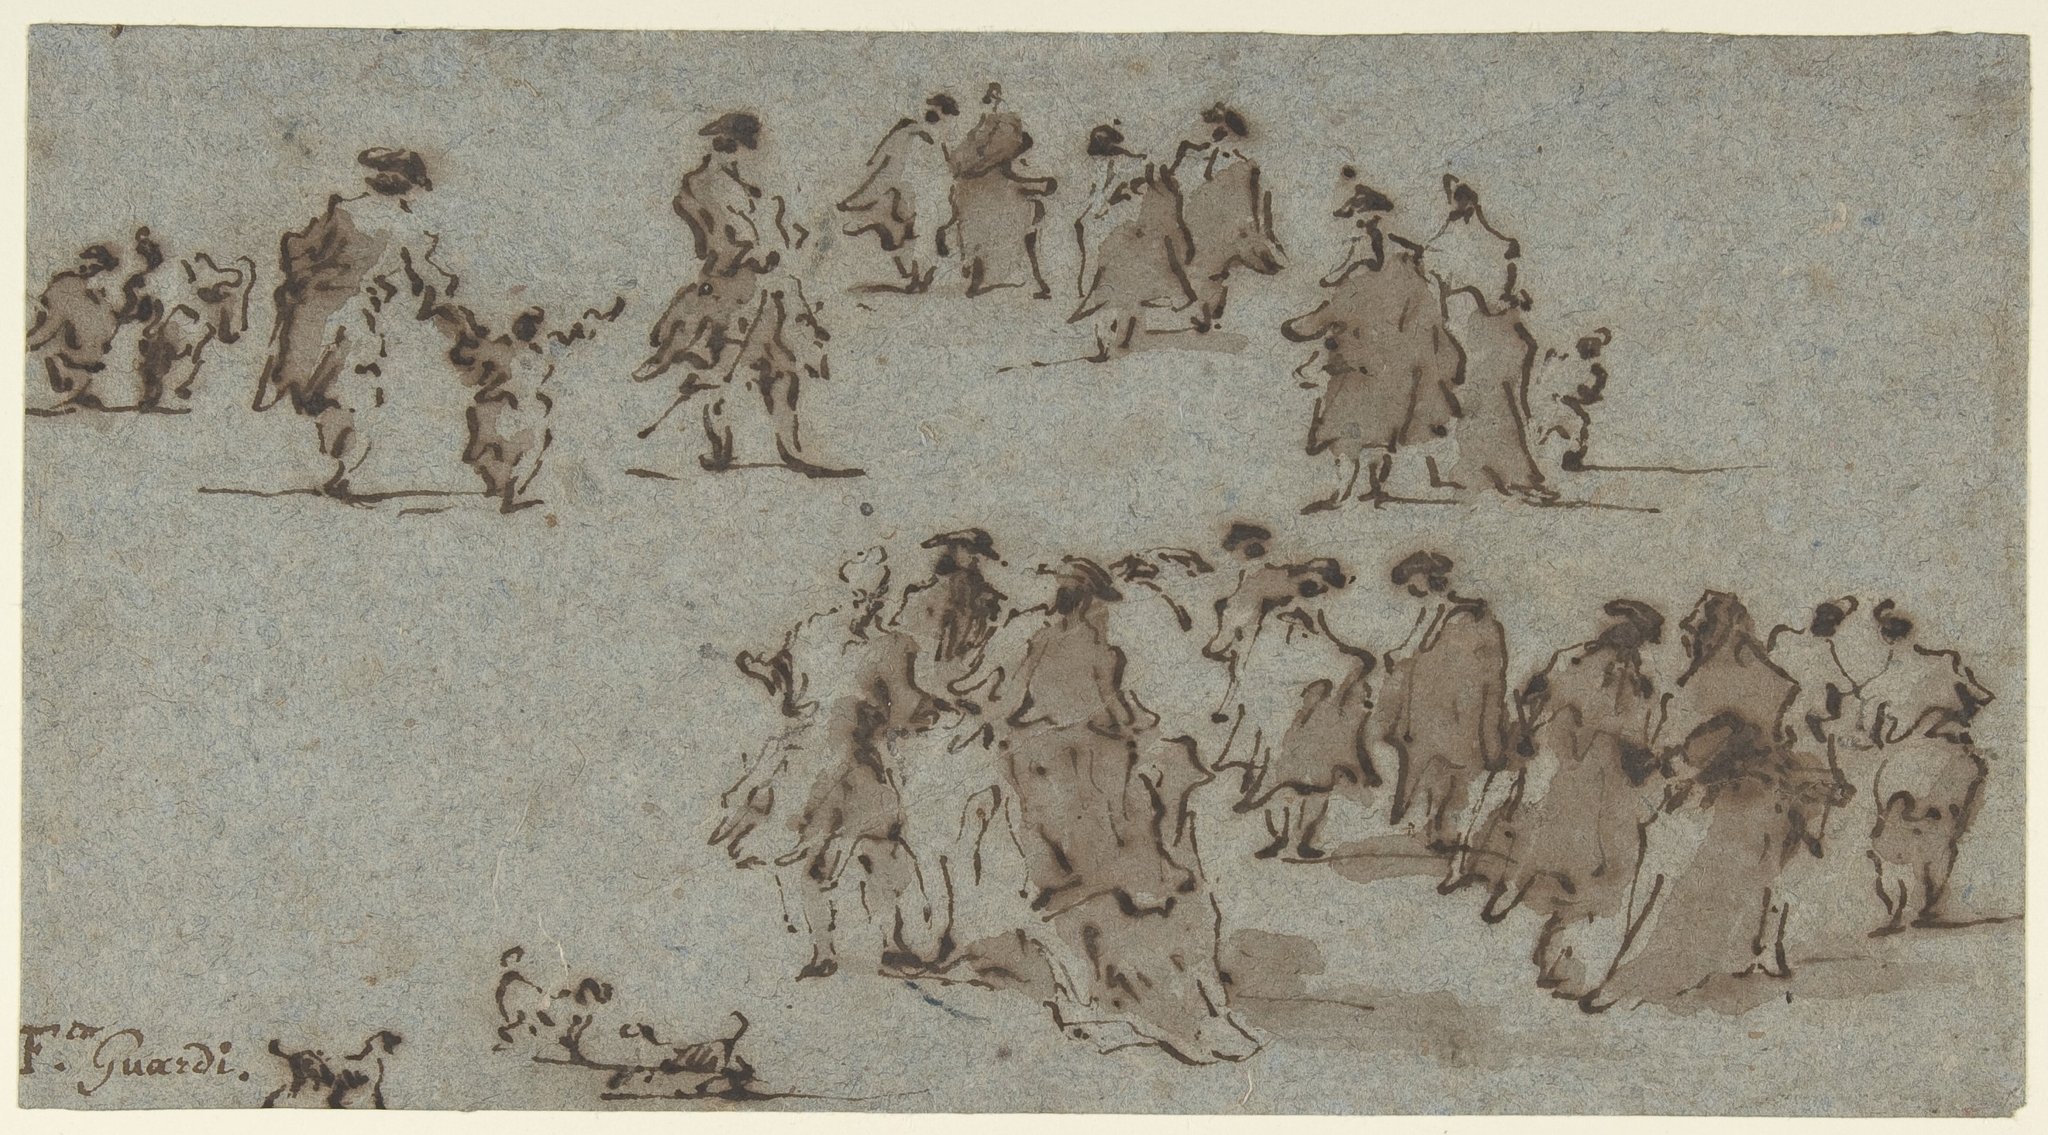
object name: drawing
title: Studies for Groups of Walking Dressed Figures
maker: francesco guardi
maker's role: artist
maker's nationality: italian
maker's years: 1712-1793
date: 1712-1793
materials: ink, paper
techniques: brush, pen, wash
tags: human figures,walking